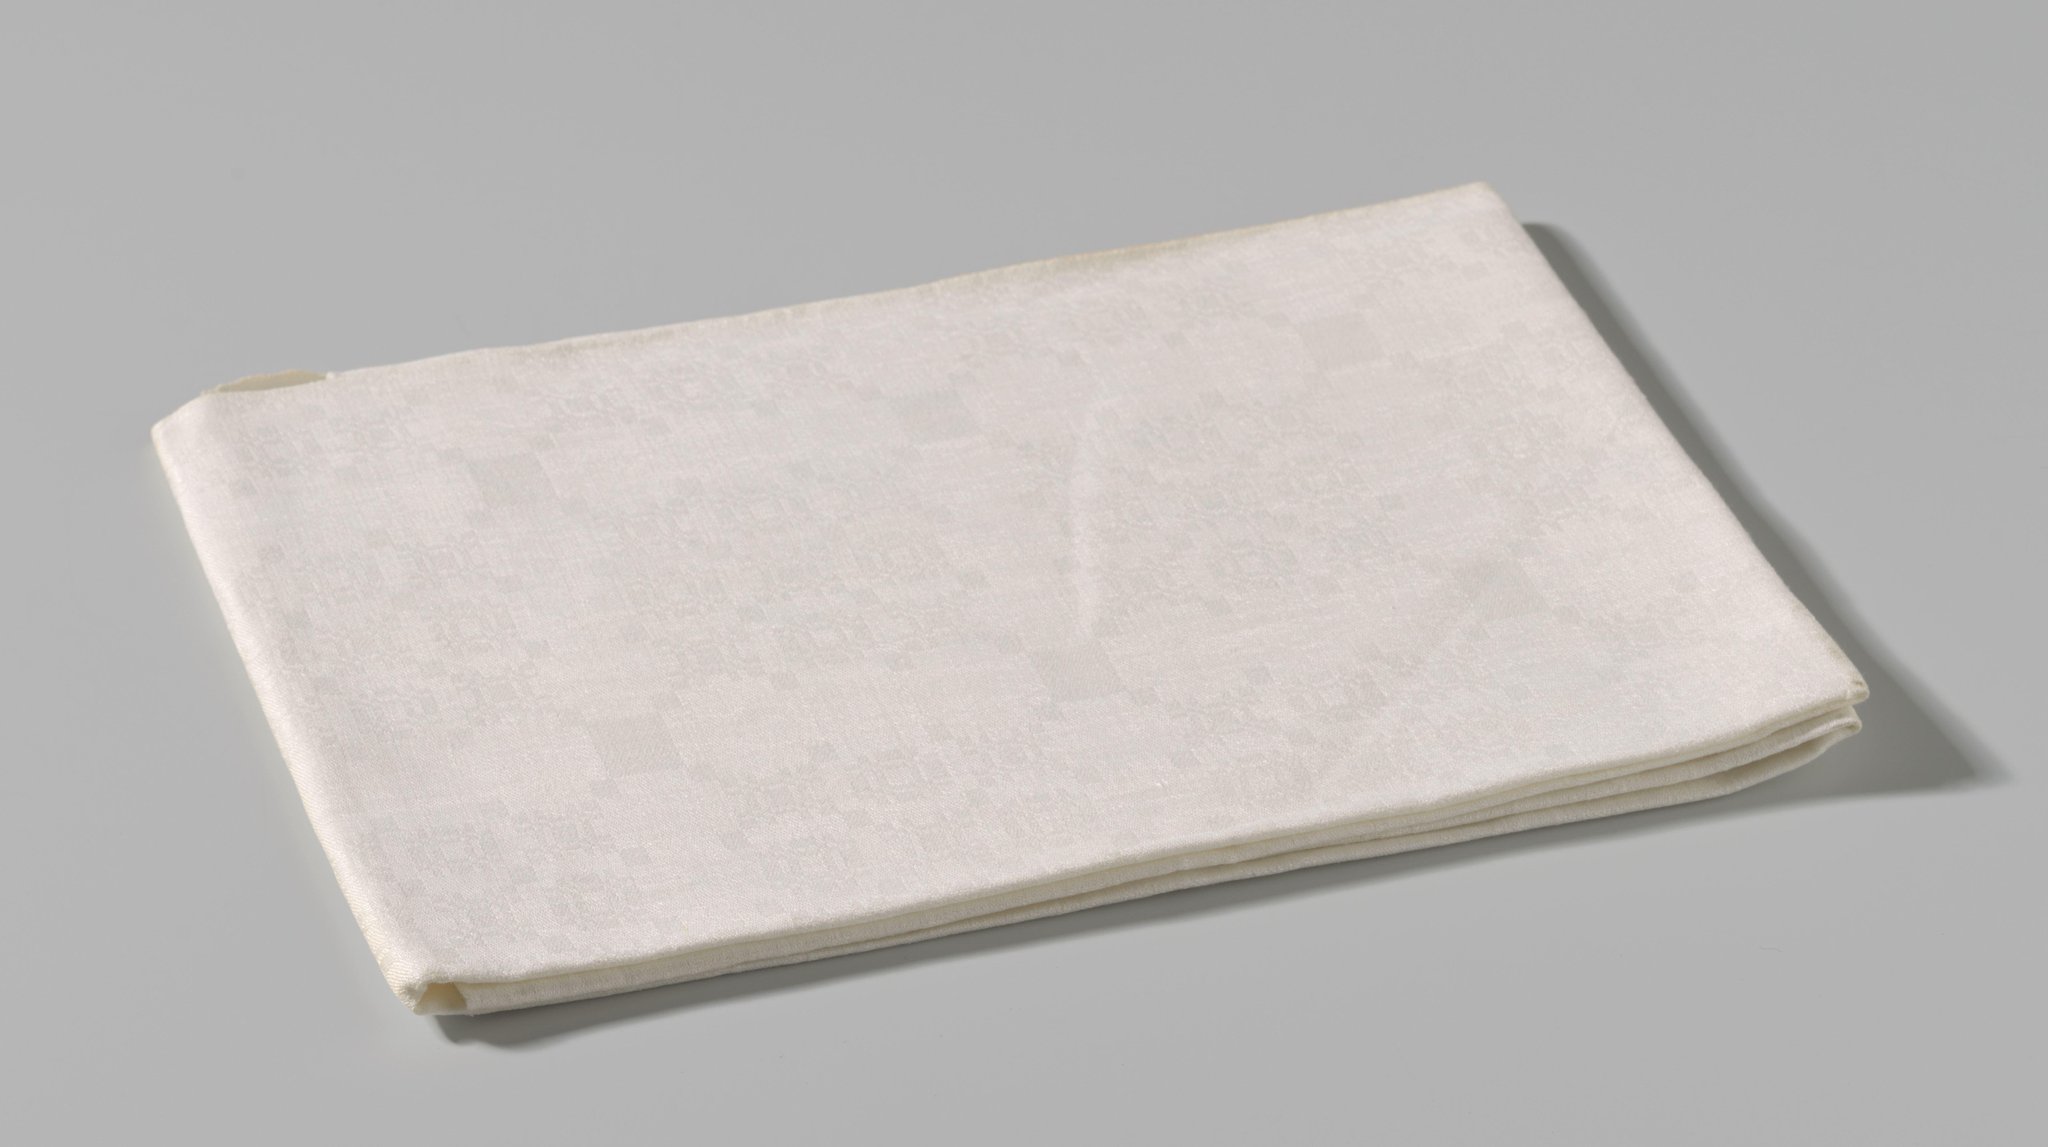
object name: napkin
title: Servet van linnen met pellenpatroon en randen rondom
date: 1700-1799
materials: linen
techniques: peeled fabric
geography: netherlands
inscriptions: mark: ‘WS’, mark: ‘LRV23’, mark: ‘100’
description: Servet van linnen met pellenpatroon en randen rondom. Een blok van dire maal drie pellen, om en om beeld en tegenbeeld, met een blok op de hoeken van drie patronen. Op de hoeken van deze figuren een reuze 'speldenkussen'. Merken: oorspronkelijk blauwe kruissteek WS en 100 en LRV2 of LRH23.